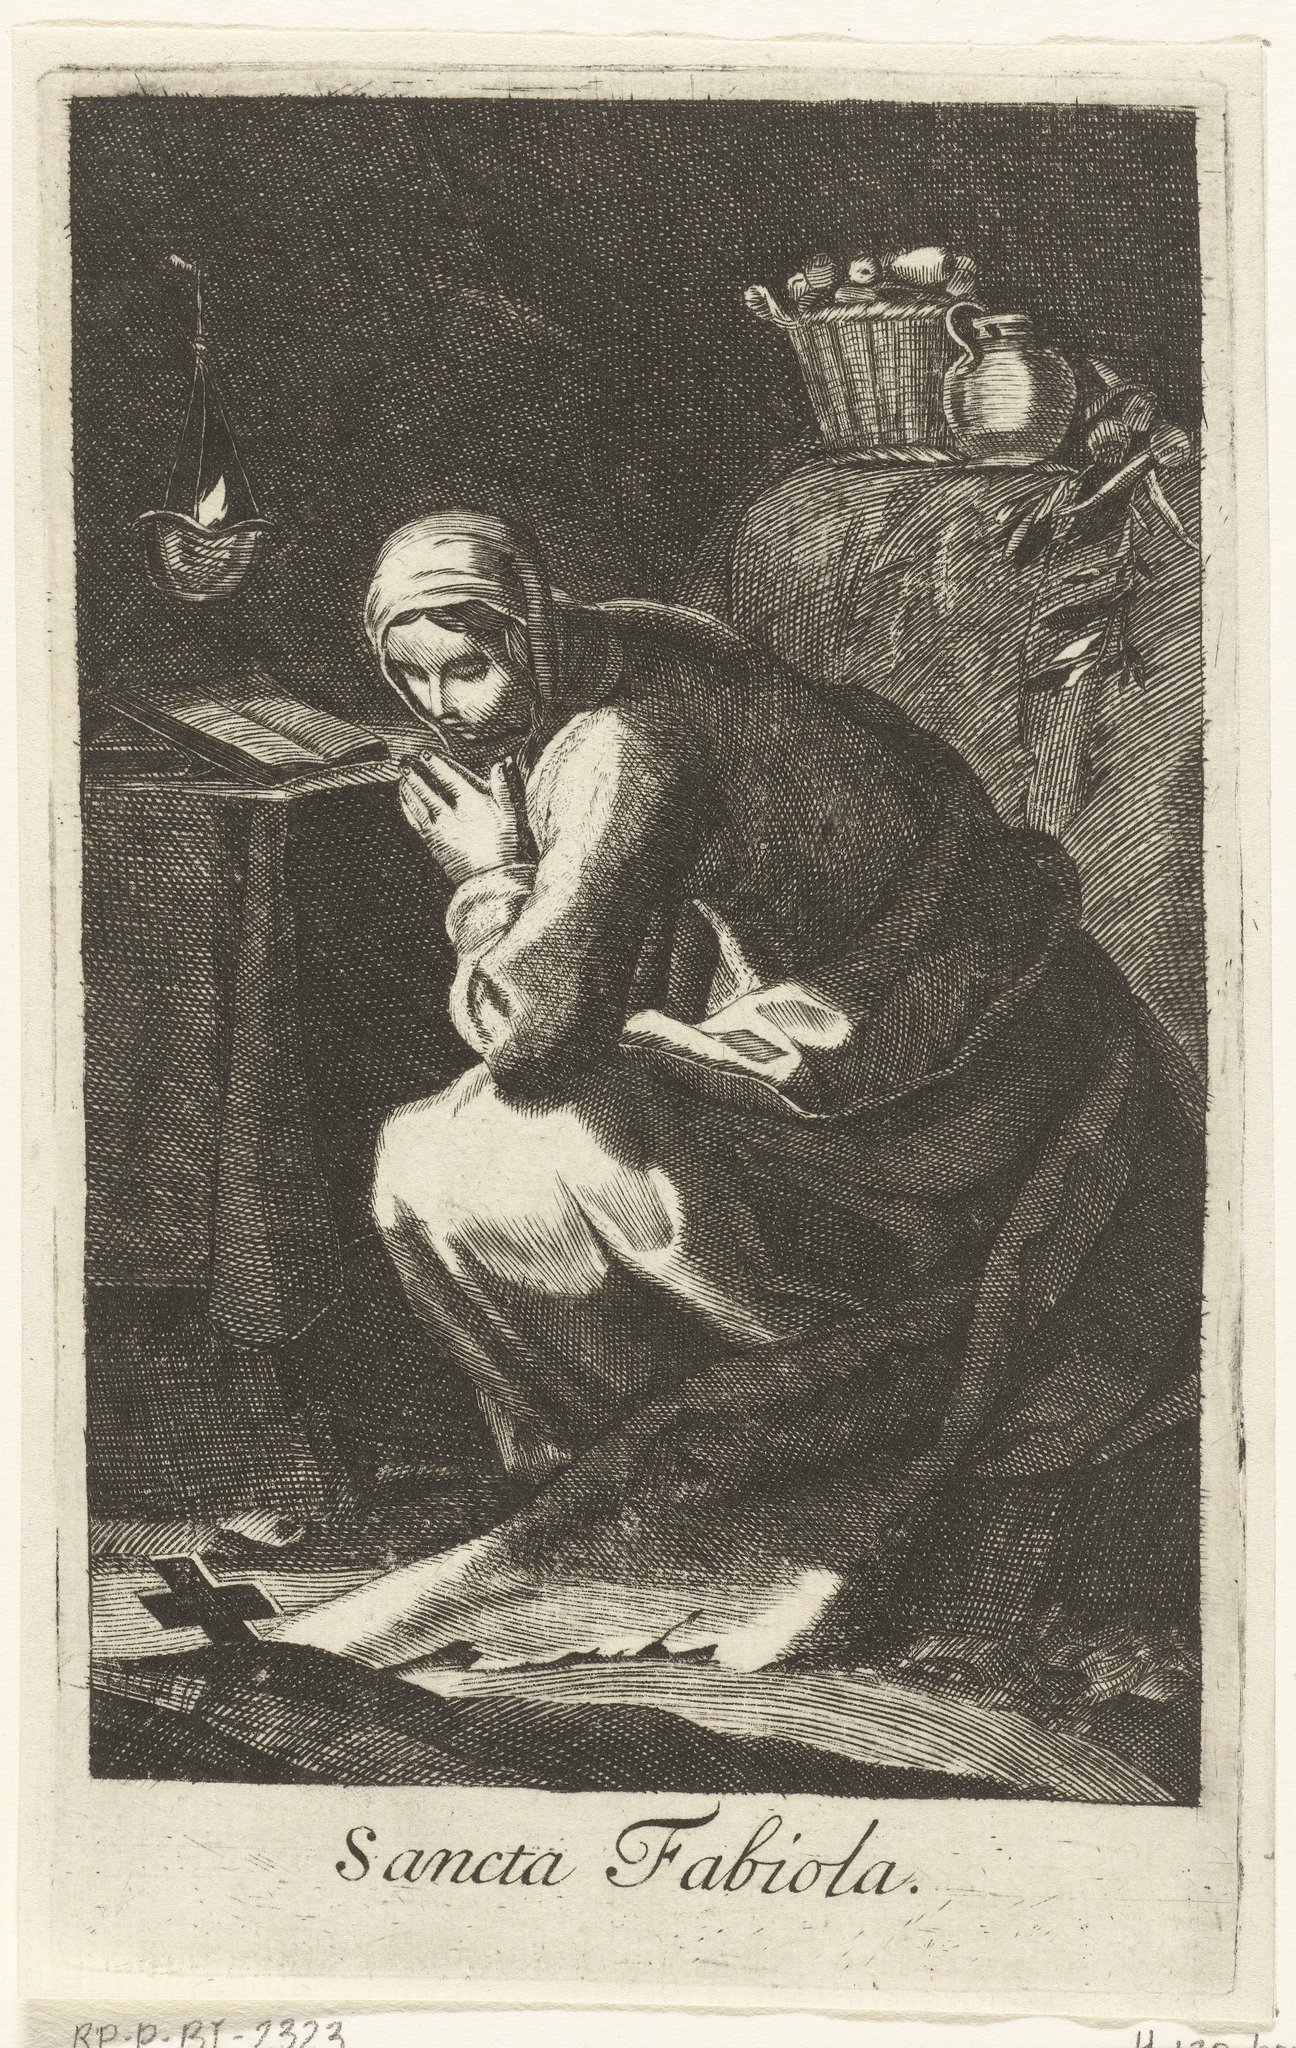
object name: print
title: Sancta Fabiola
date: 1590-1662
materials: paper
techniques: engraving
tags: anchorite, hermit, female saints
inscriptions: collector's mark: Lugt 2228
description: Kopie in spiegelbeeld naar prent van Boëtius Adamsz. Bolswert uit serie Kluizenaressen.